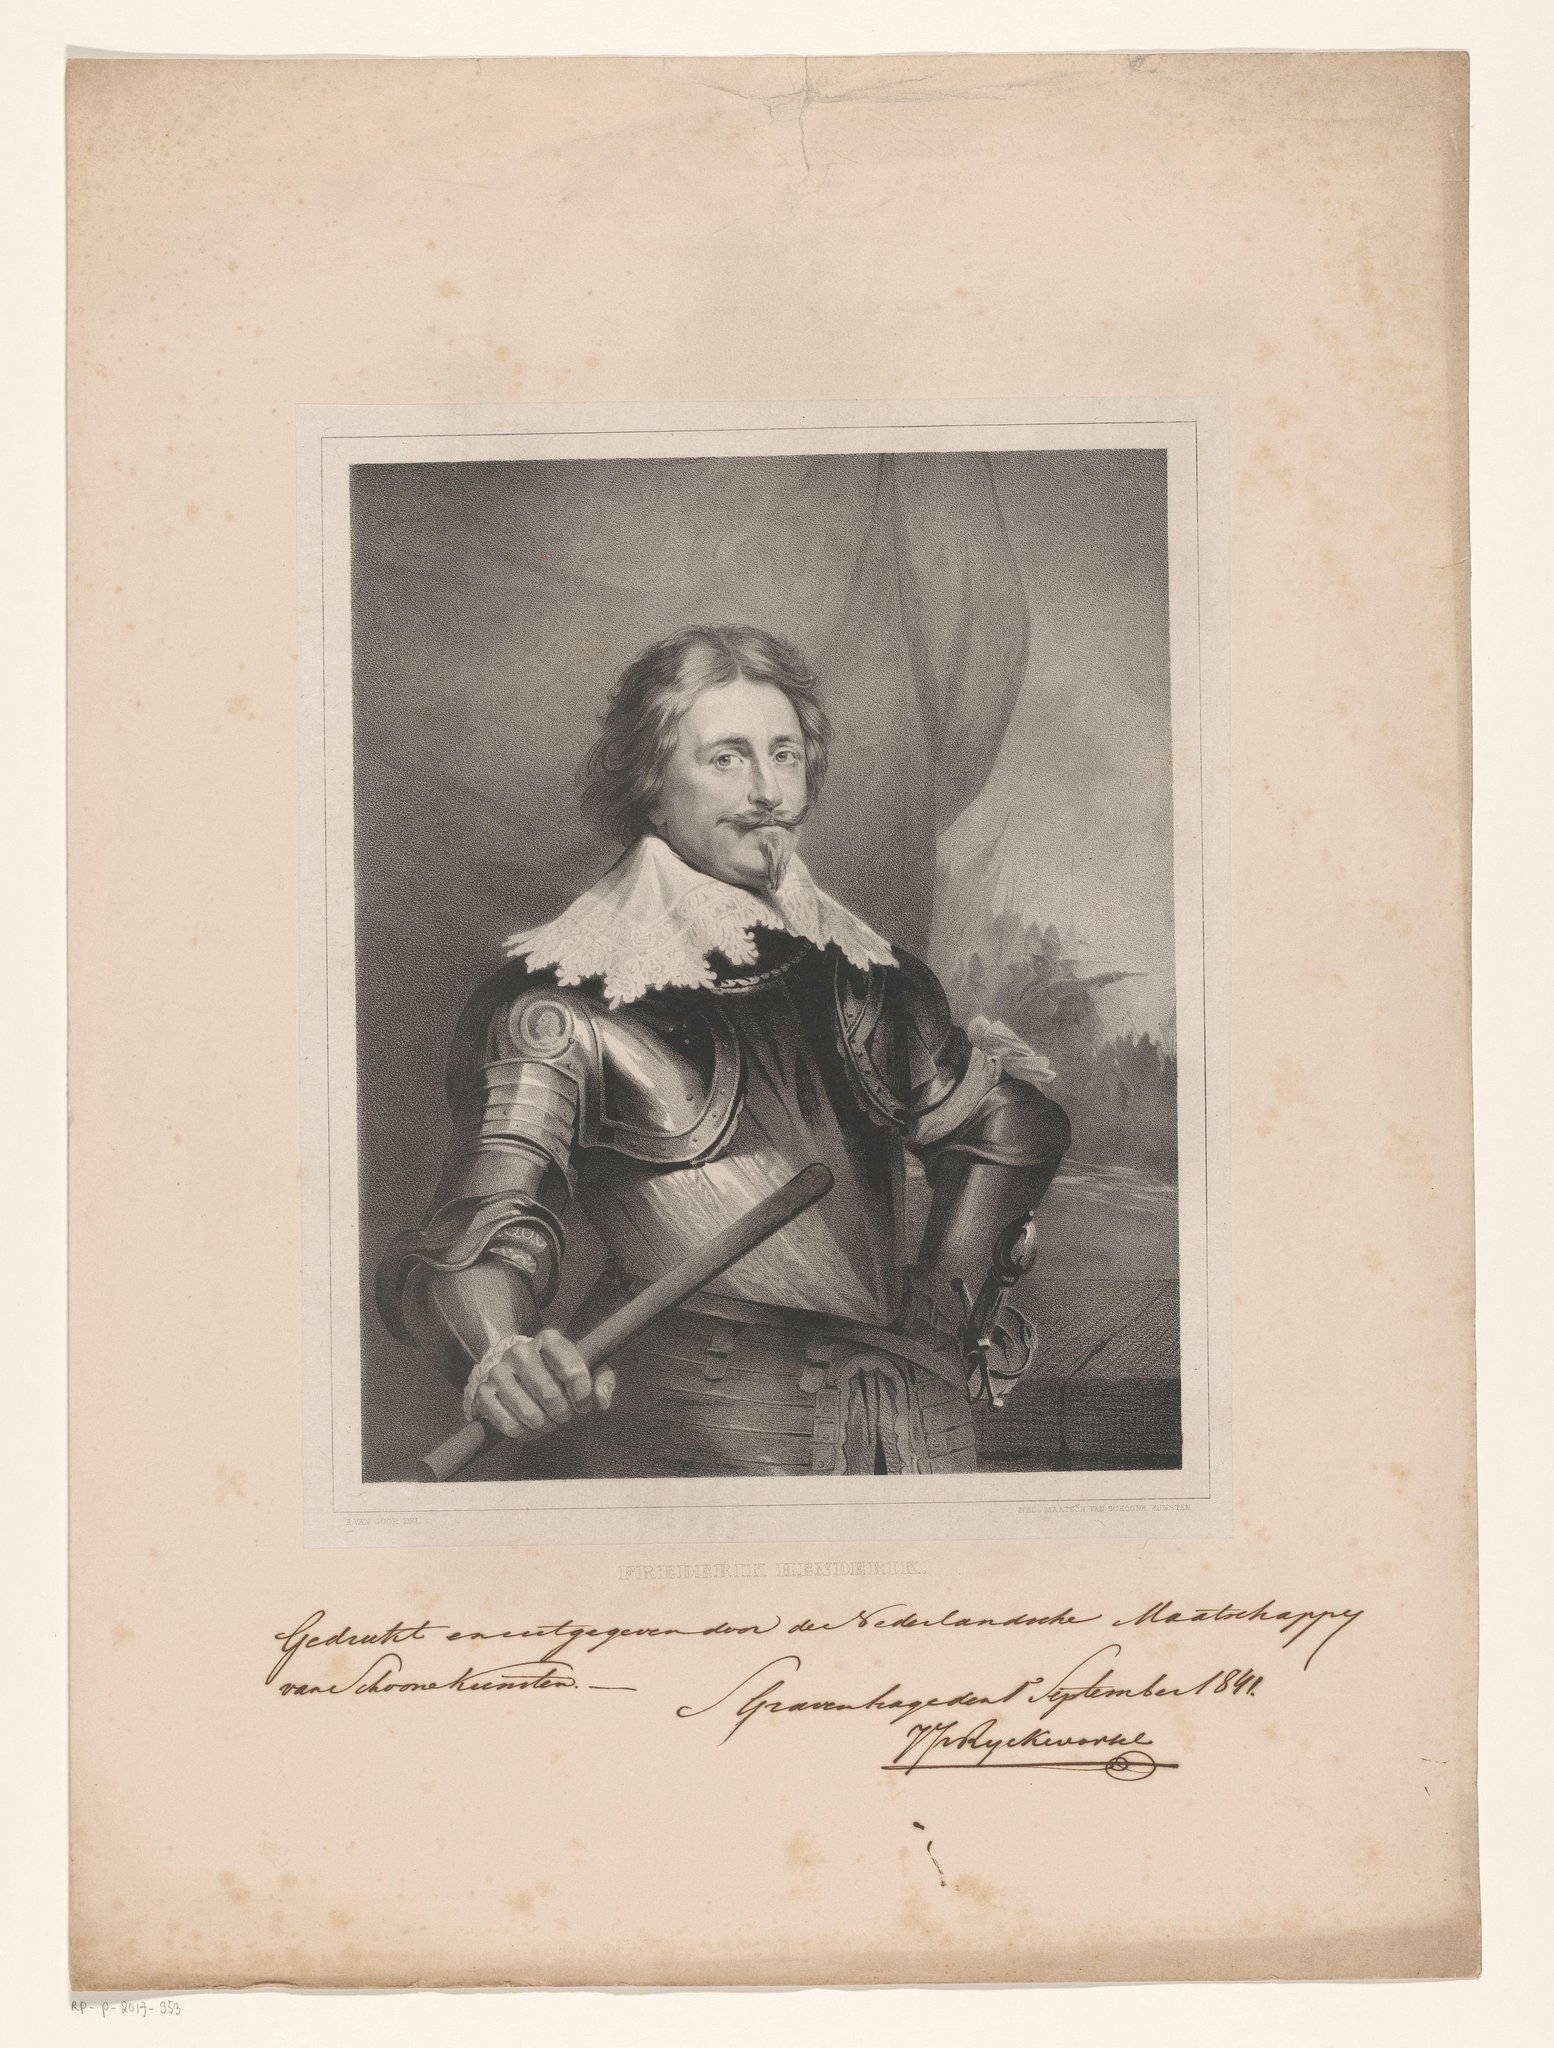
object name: print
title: Portret van Frederik Hendrik van Oranje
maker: f. van goor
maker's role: print maker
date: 1841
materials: paper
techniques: lithograph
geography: the hague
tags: delft, the hague, frederick henry (prince of orange), historical persons (+ half-length portrait), baton of general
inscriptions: : ‘Gedrukt en uitgegeven door der Nederlandsche Maatschappij / van Schoone Kunsten / S Gravenhage, 1 september 1841 / JJvRijckevorsel’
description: Deze prent was onderdeel van: Valhalla : galerij van vermaarde Nederlandsche mannen: geschiedkundige portretten door de voornaamste Nederlandsche kunstenaars geteekend: met beschrijving. Den Haag: Nederlandsche Maatschappij voor Schoone Kunsten, 1841.